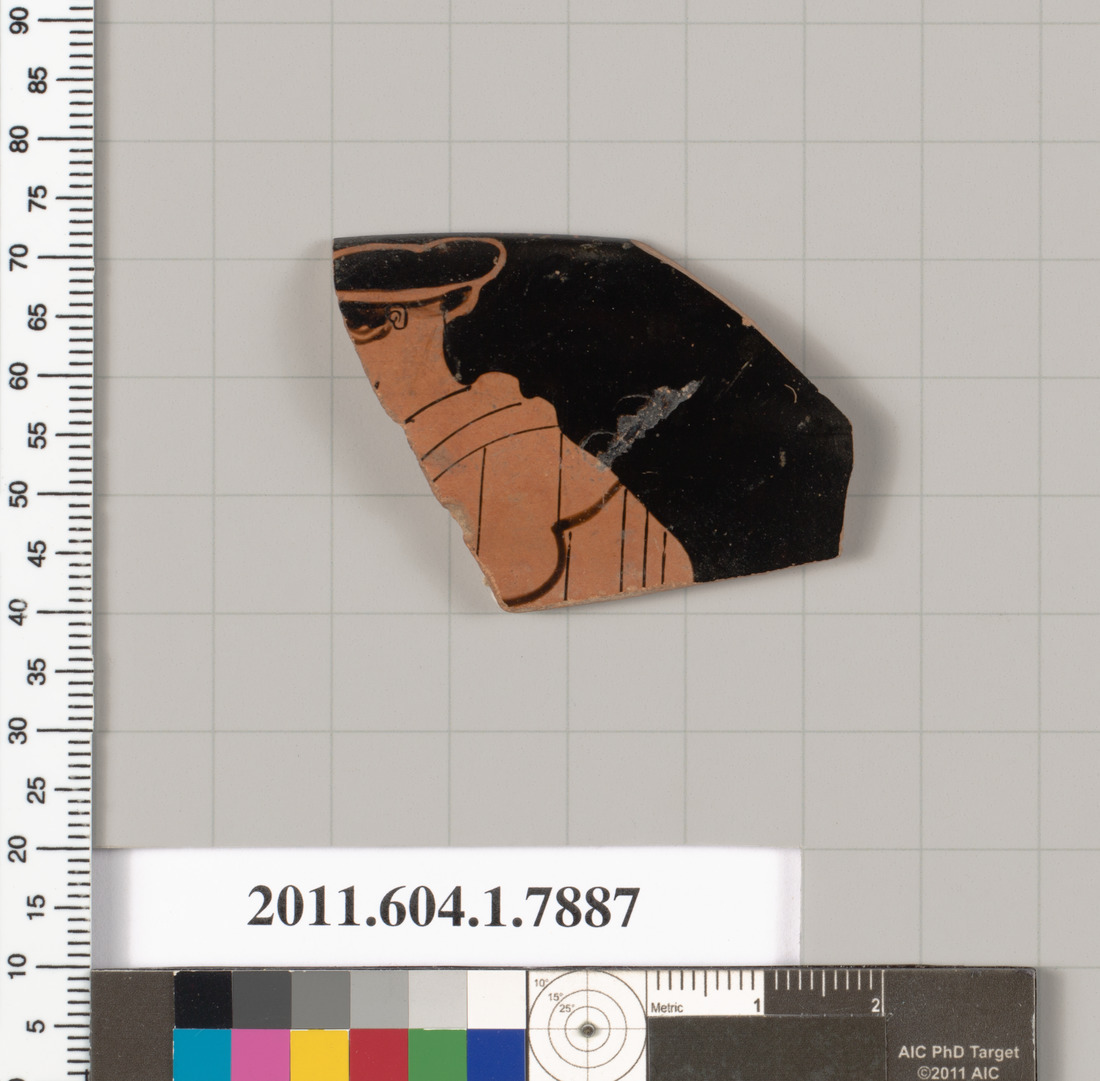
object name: kylix fragment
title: Terracotta rim fragment of a kylix (drinking cup)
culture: greek, attic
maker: wedding painter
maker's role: artist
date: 460-450 BCE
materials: terracotta